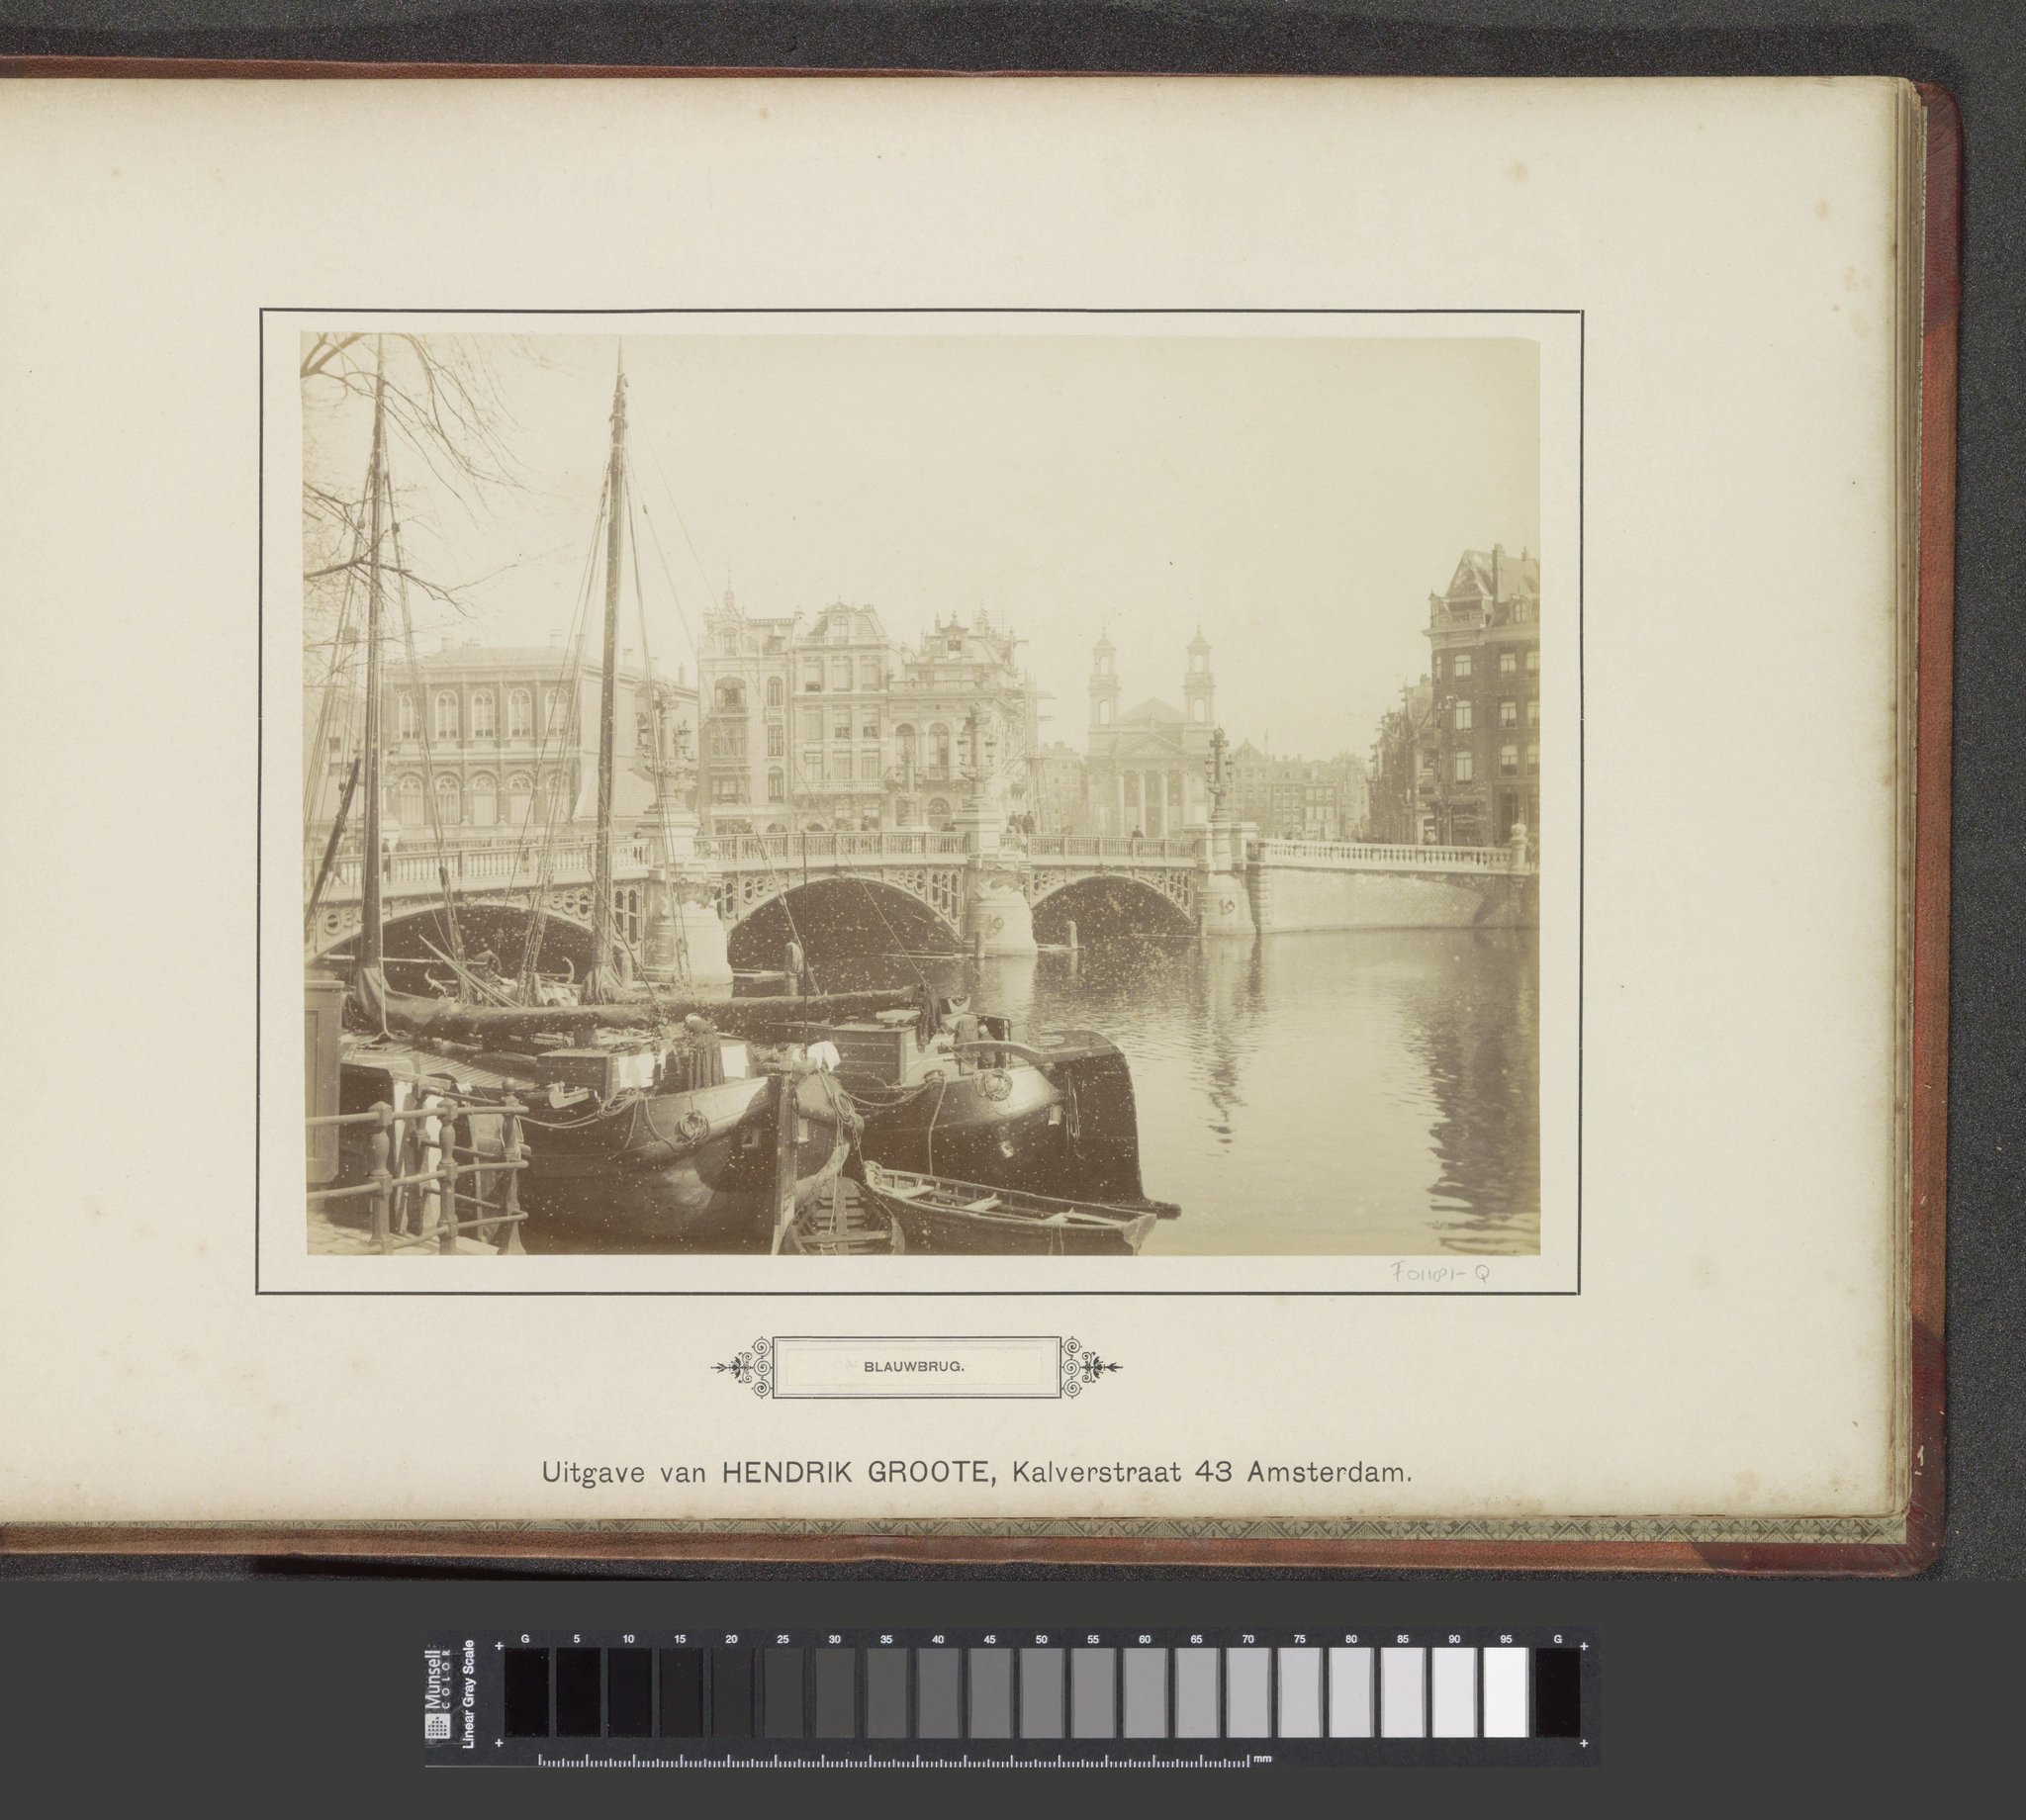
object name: photograph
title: Blauwbrug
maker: Anonymous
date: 1880-1895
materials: photographic support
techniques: albumen print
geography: amsterdam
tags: church (exterior), bridge in city across river, canal, etc.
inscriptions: inscription: ‘Hendrik Groote Kalverstraat 43, Amsterdam. Photographic stores. Views from Holland. Photographs from ancient and modern dutch Paintings. Fines ans most complete Collection.’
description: Onderdeel van Fotoalbum met opnames van het centrum van Amsterdam en reclameteksten voor winkels en bedrijven.